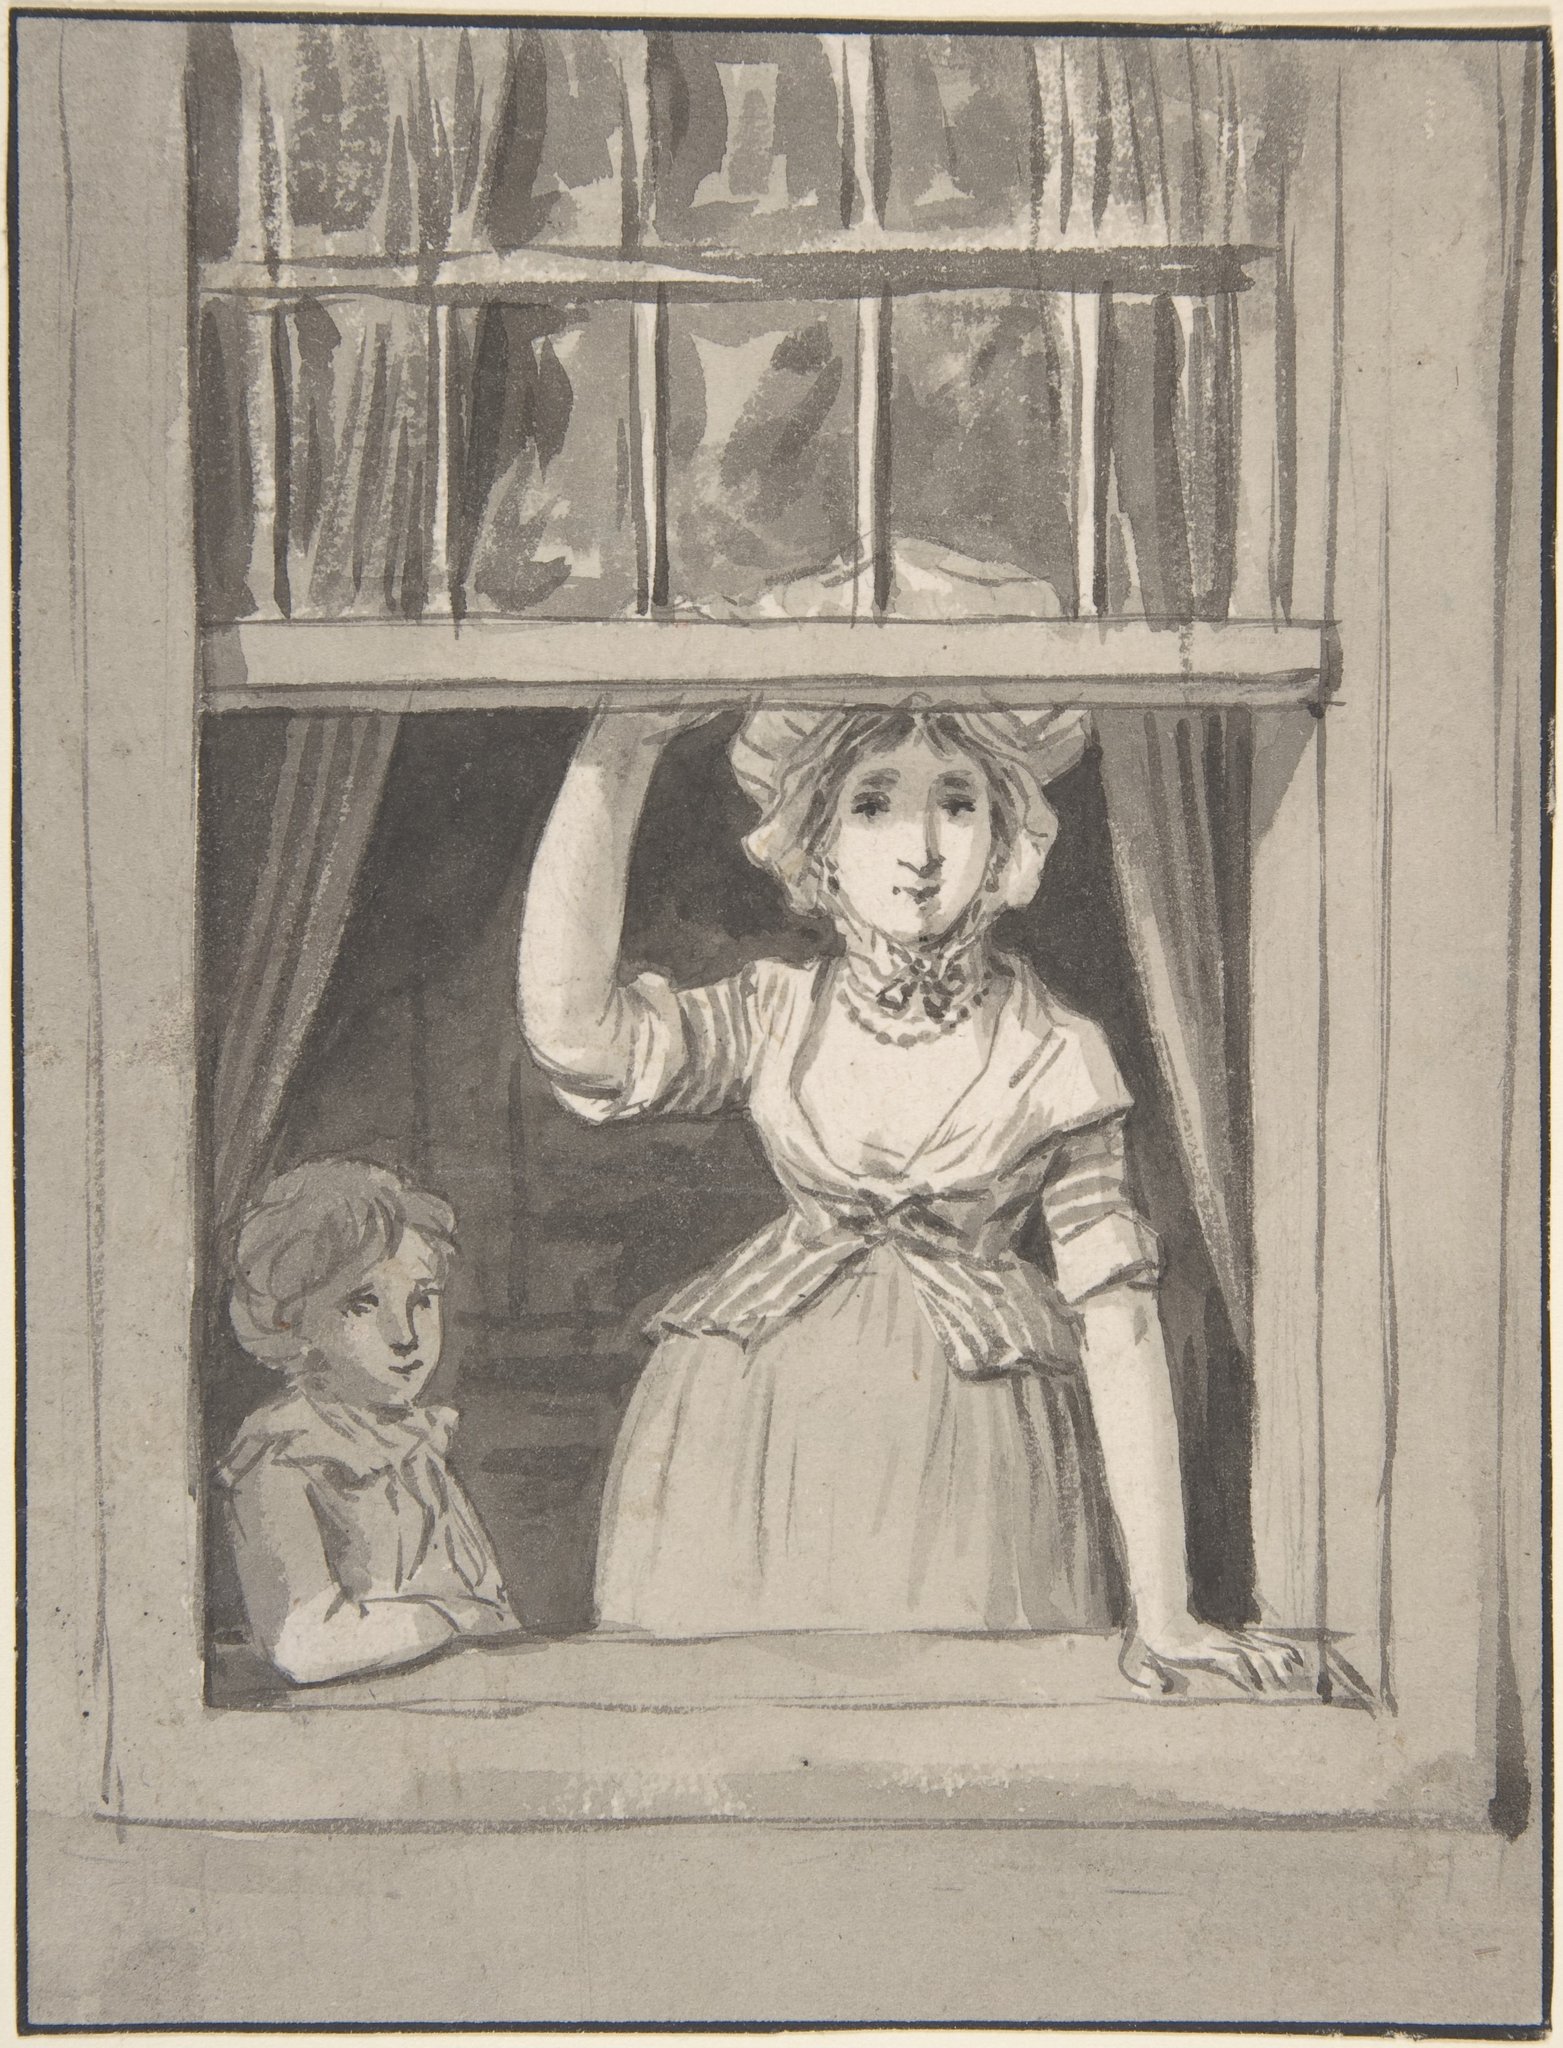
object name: drawing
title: A Woman Standing at an Open Sash Window, a Small Boy Beside Her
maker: anthonie andriessen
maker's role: artist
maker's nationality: dutch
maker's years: 1746-1813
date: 1761-1813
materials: ink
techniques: brush, pen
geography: netherlands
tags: windows,boys,women